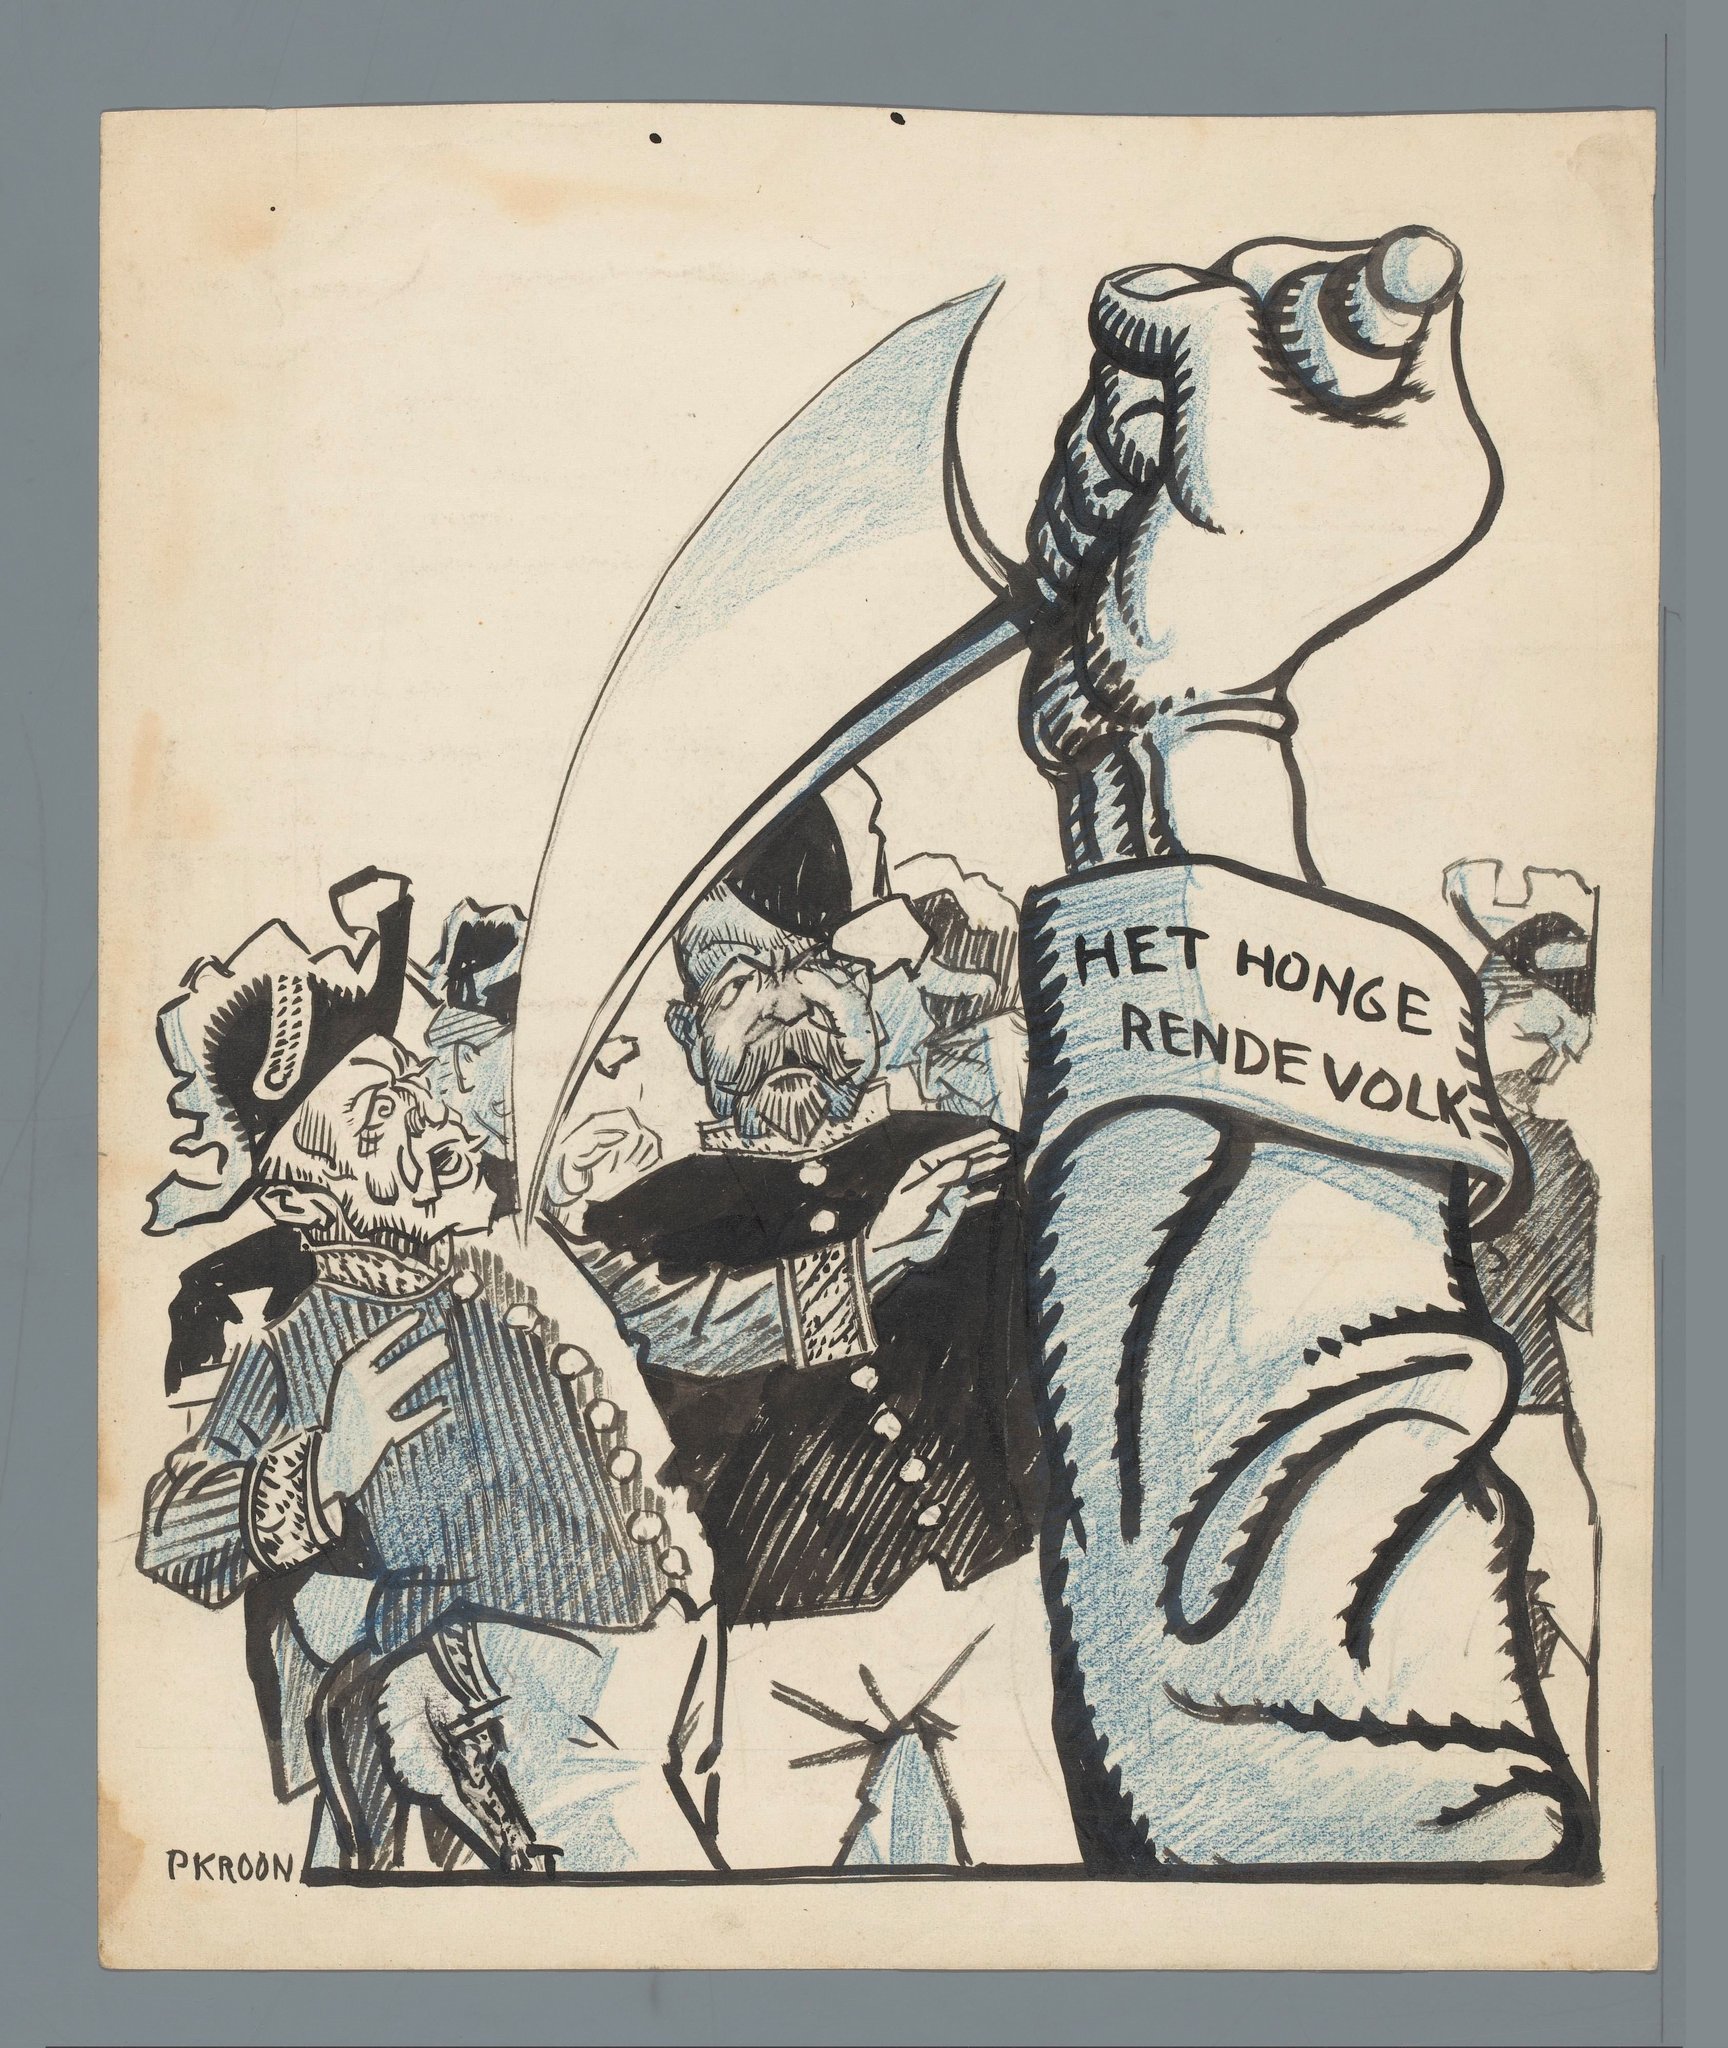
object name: cartoon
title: Ministers bedreigd door het hongerige volk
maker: patricq kroon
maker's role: draughtsman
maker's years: 1862-1941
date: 1900-1935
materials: chalk, ink, paper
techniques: brush, pen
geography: netherlands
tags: hunger, minister ~ government, political caricatures and satires, netherlands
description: Enkele ministers worden bedreigd door een opgeheven hand met een mes, op de mouw aangeduid als 'het hongerende volk'. Ontwerp voor een politieke spotprent.